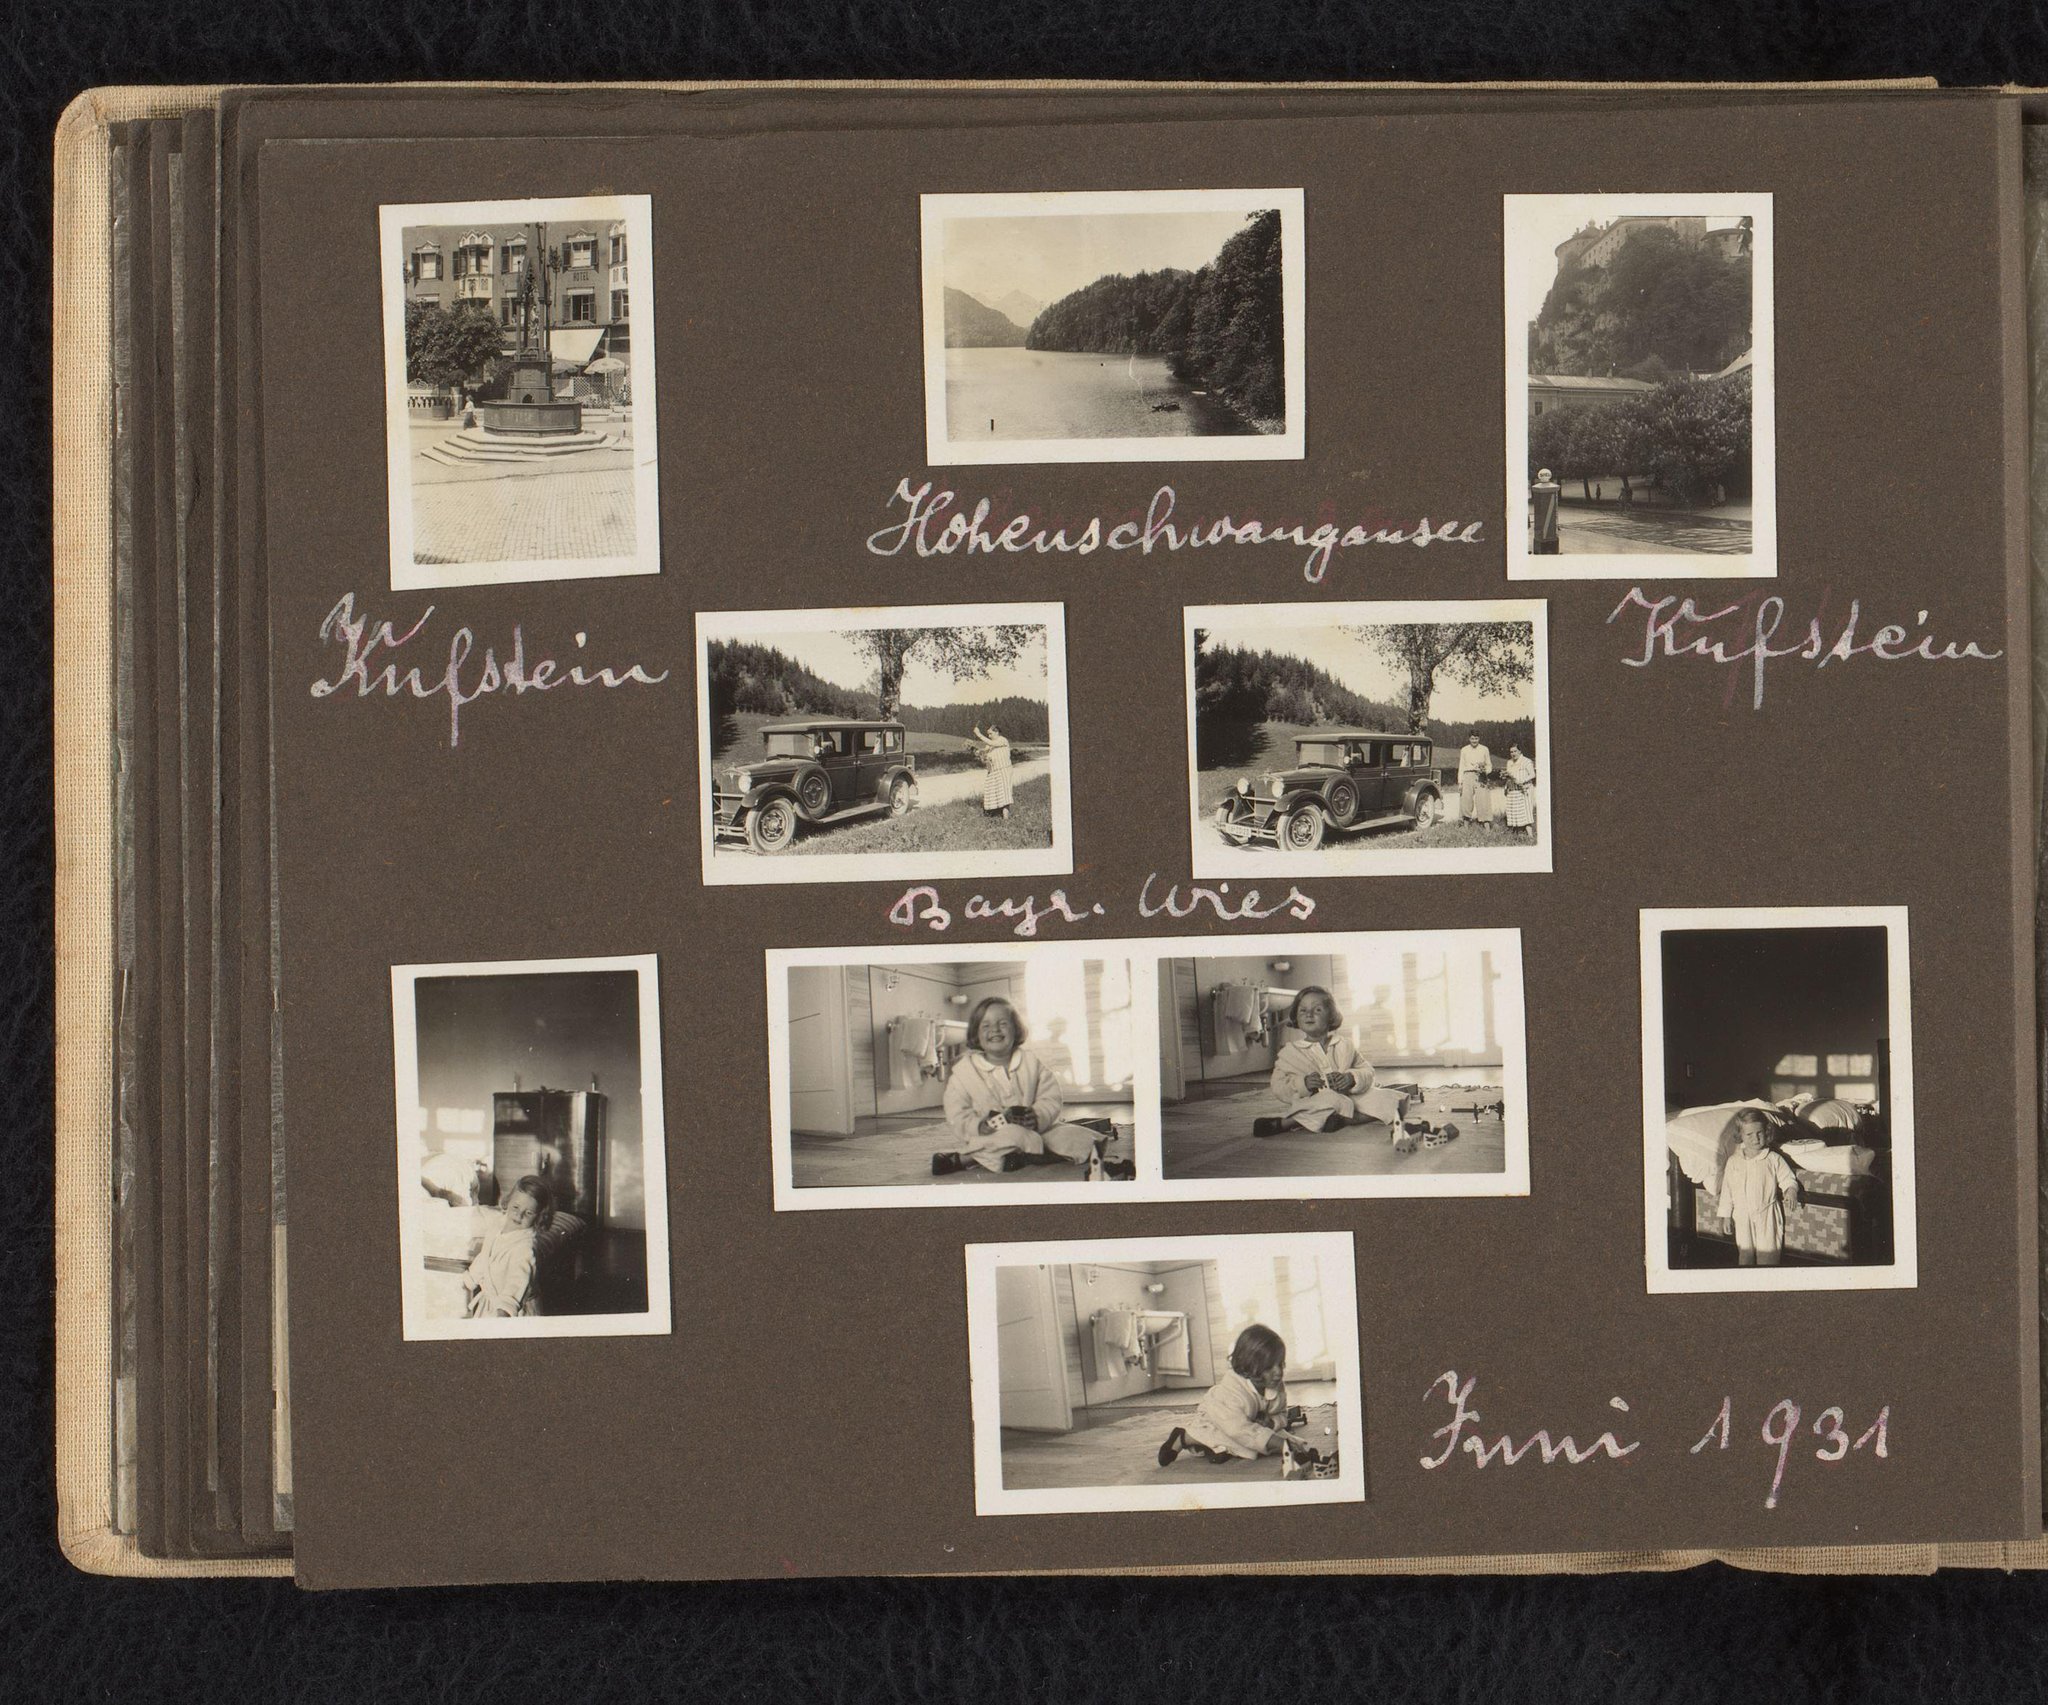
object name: album leaf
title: Vakantiefoto's van Hohenschwangau en Isabel Wachenheimer spelend op de grond, juni 1931, München en Beieren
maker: else wachenheimer-moos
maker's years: 1895-1944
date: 1906-1931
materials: cardboard, photographic support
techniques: gelatin silver print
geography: germany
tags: leiden, isabel wachenheimer-elon, the family travelling, on holiday, family life at home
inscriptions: inscription: ‘Kufstein Hohenschwangausee Kufstein Bayr. Wies Juni 1931’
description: Blad bevat tien foto's. Alle foto's van Isabel Wachenheimer. Uit het album, half formaat, crèmekleurig stofomslag met koordbinding met banenmotief.